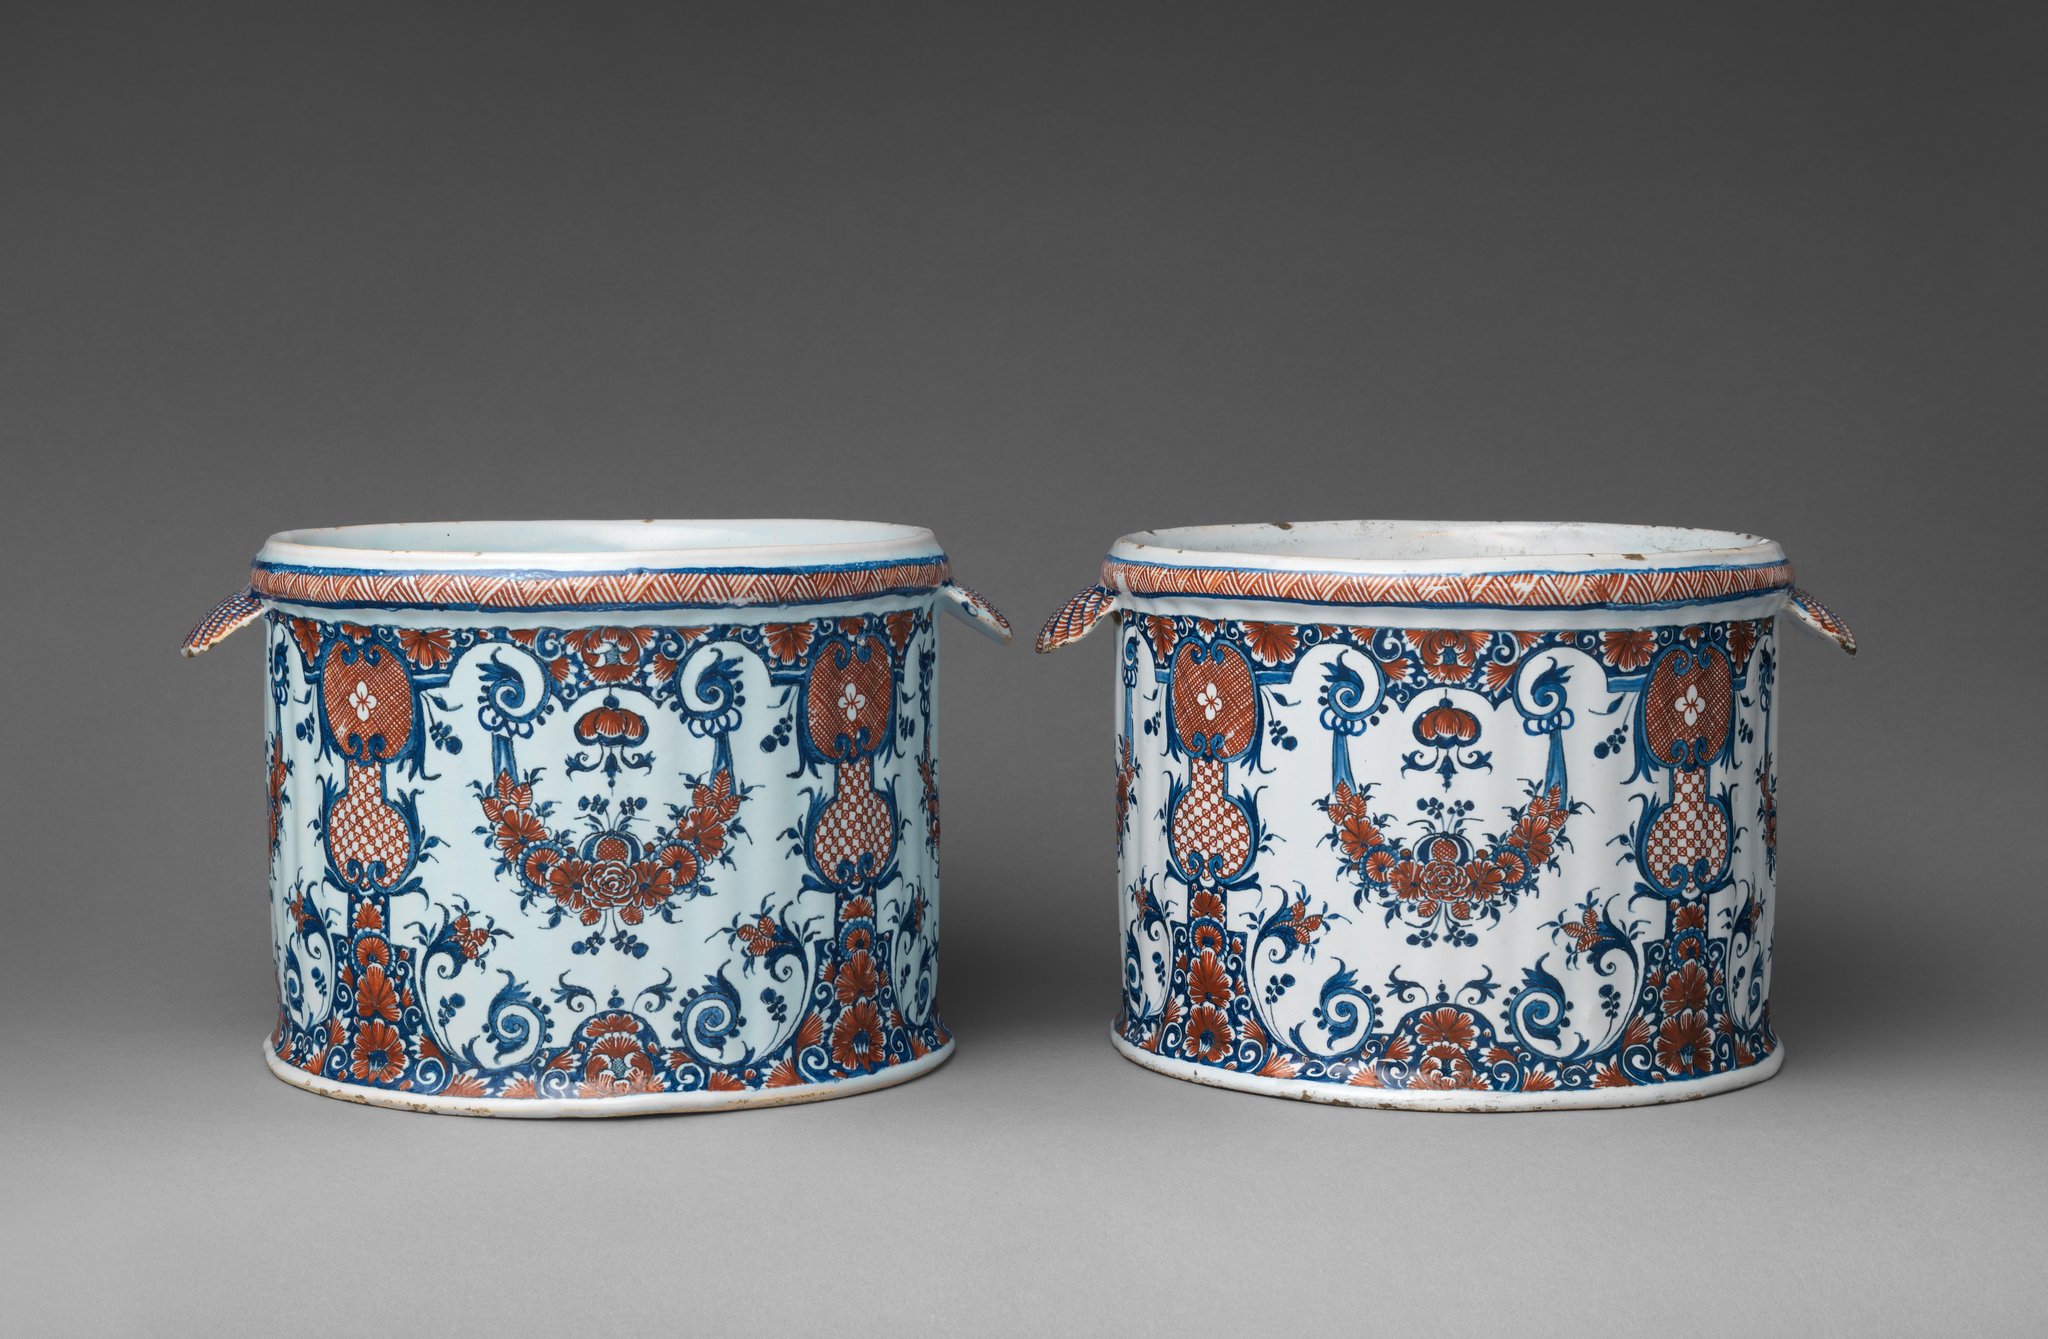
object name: jardinières or wine cooler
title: Pair of jardinières or wine coolers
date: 1725-1740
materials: faience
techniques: glazing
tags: garlands,flowers